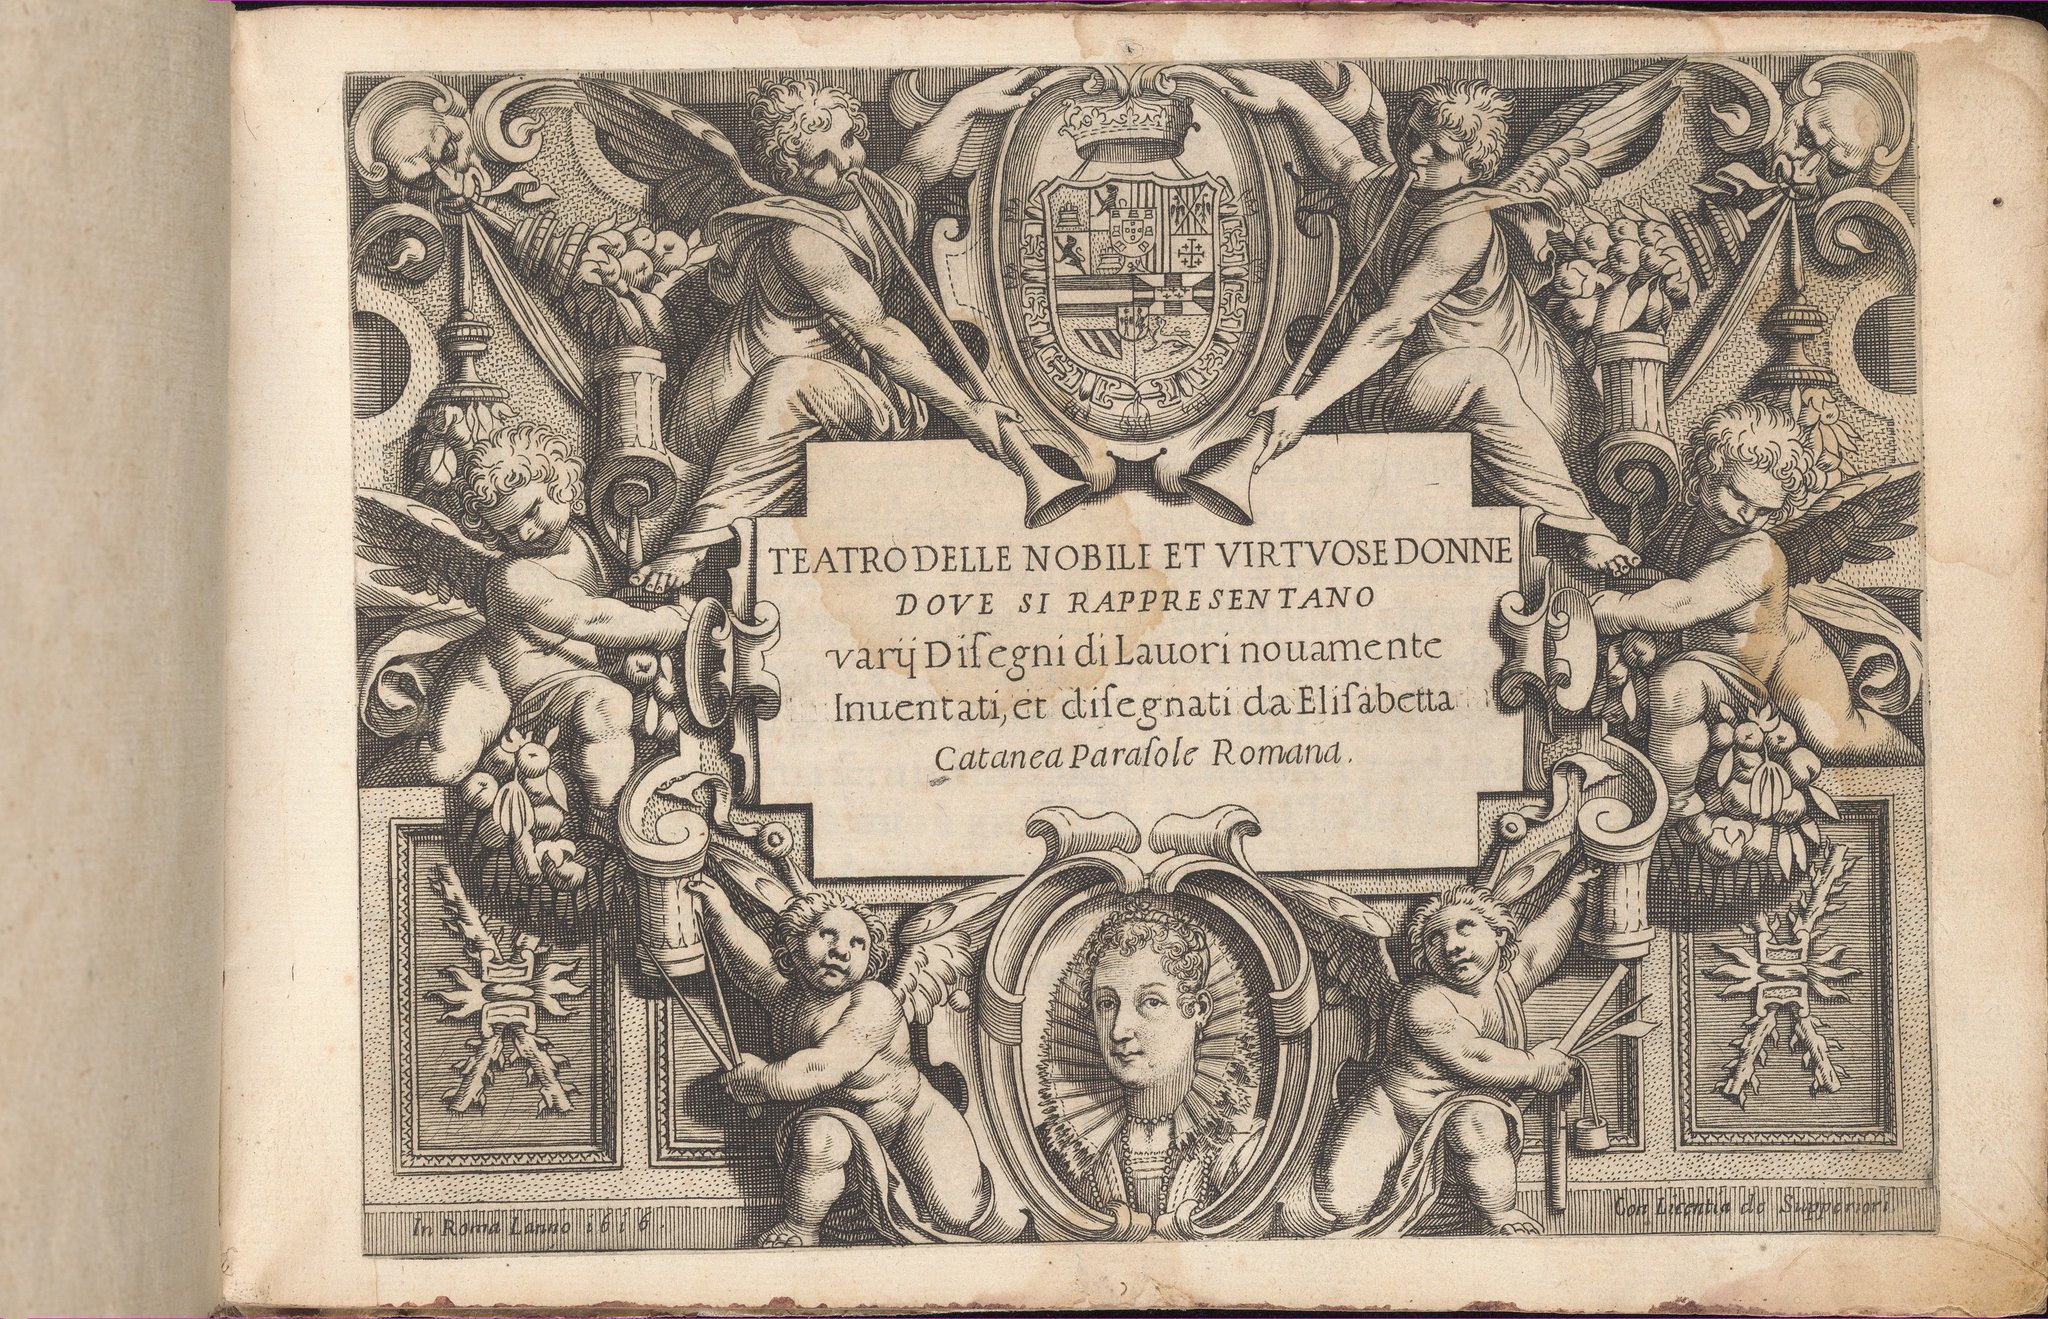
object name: book print ornament architecture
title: Teatro delle Nobili et Virtuose Donne..., title page (recto)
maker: isabella catanea parasole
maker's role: author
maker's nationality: italian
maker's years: 1565-1625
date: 1616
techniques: engraving, woodcut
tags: portraits,putti,coat of arms